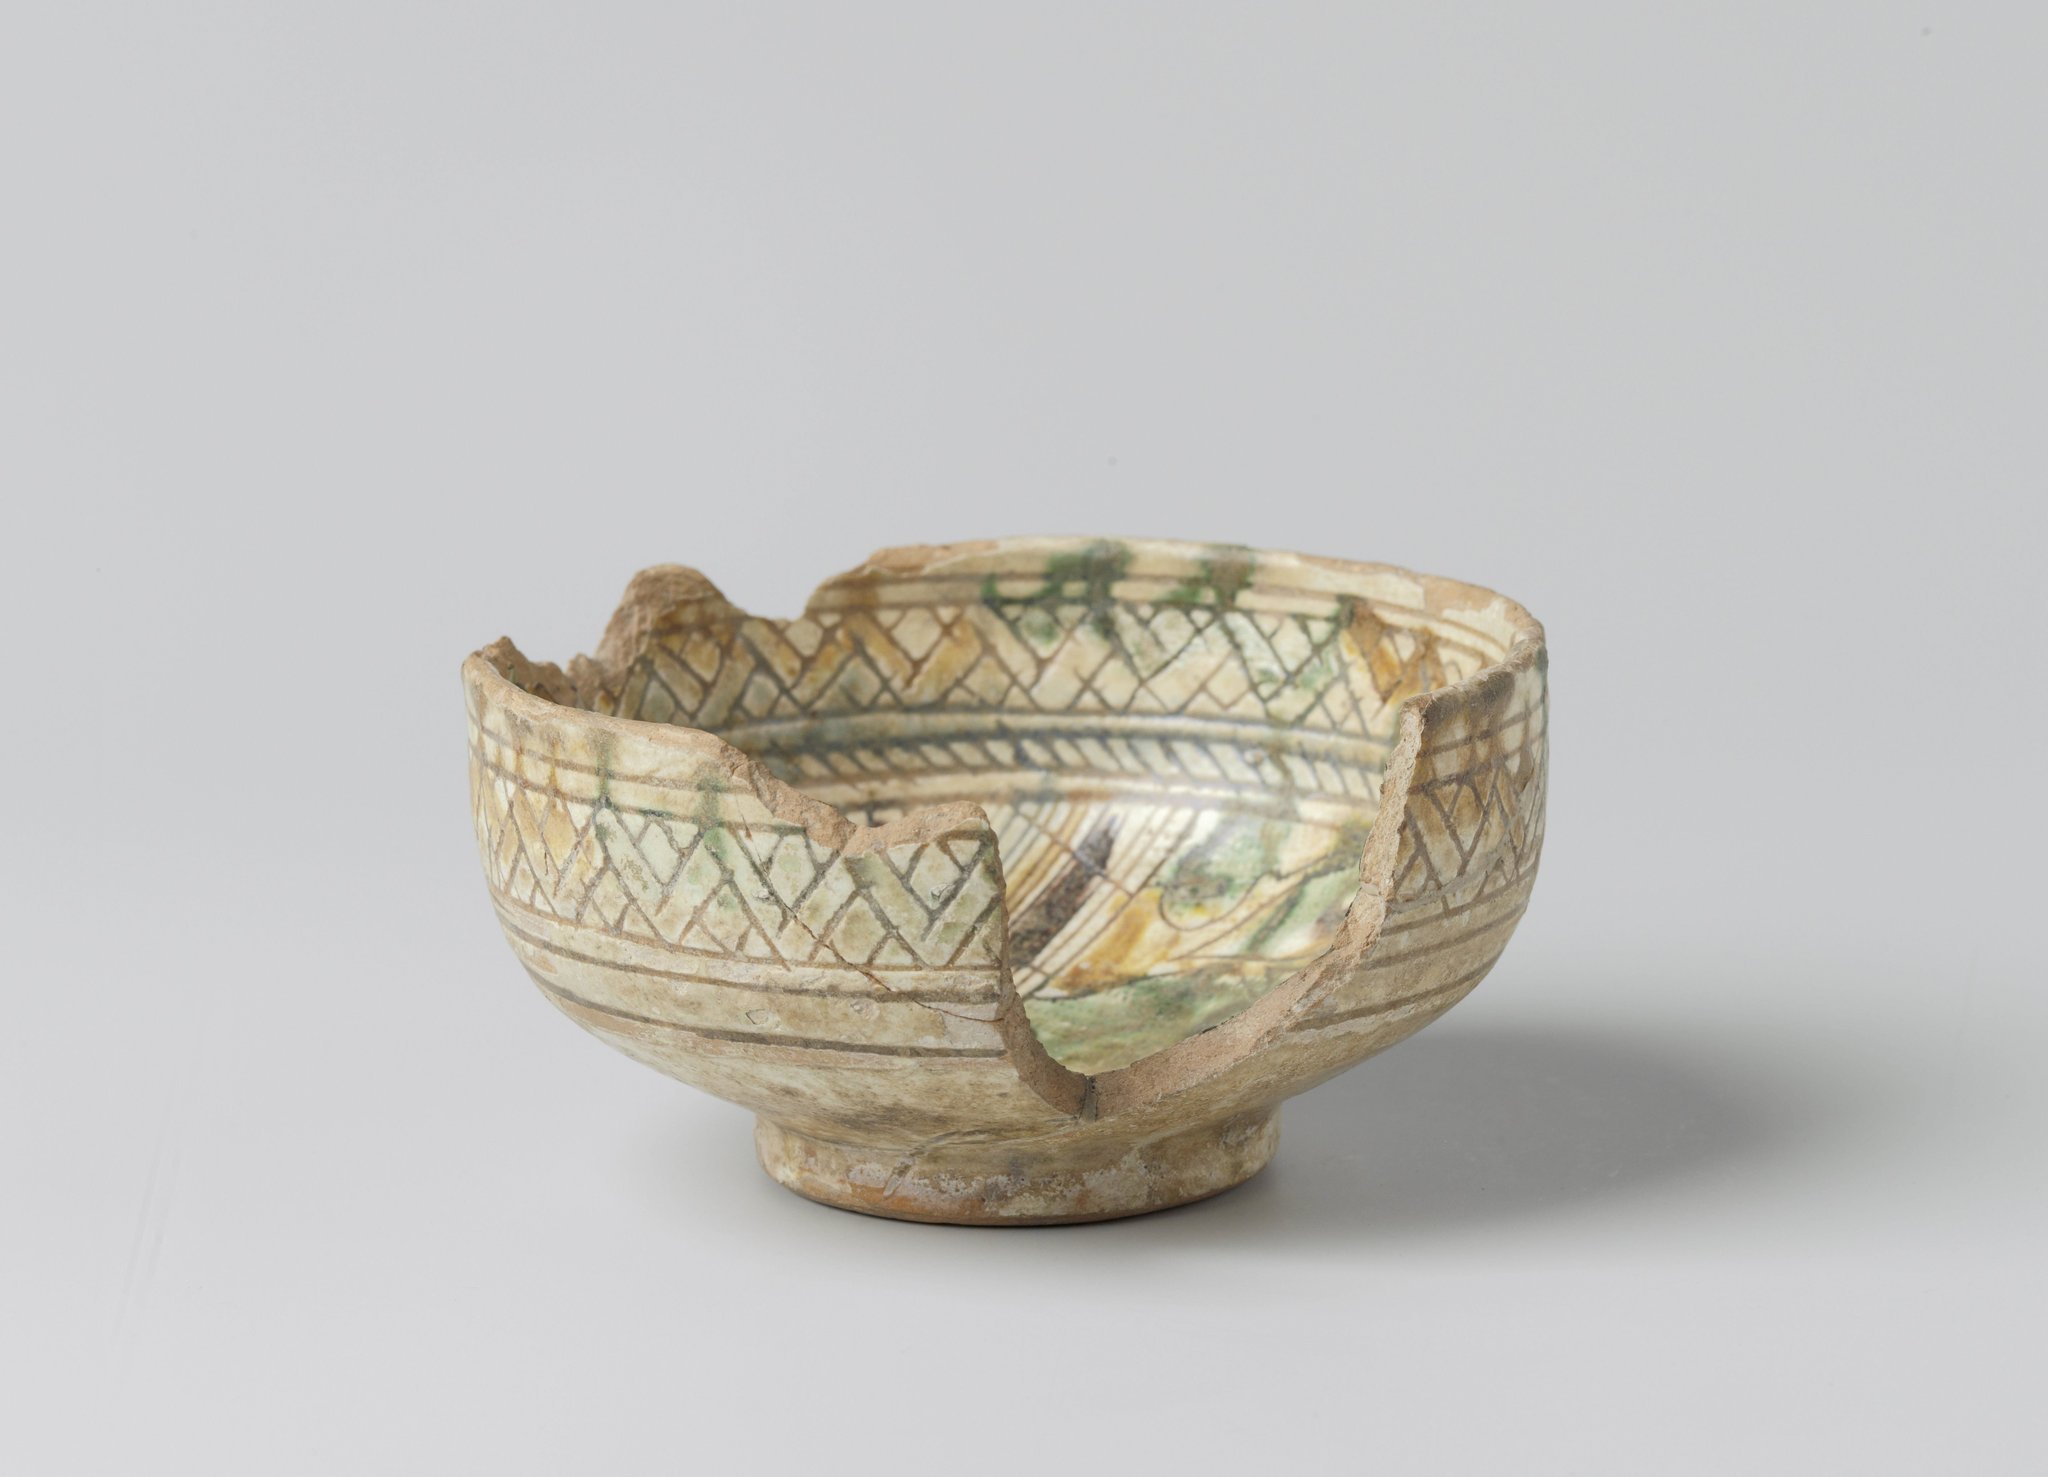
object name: scodello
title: Kom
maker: Anonymous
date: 1475-1550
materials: earthenware, glaze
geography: lombardy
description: Half bolvormige kom van veelkleurig beschilderd loodglazuur aardewerk. Op de binnenkant van de kom is een portret geschilderd van een naar links gewende vrouw. Langs de rand zijn geometrische banden geschilderd.